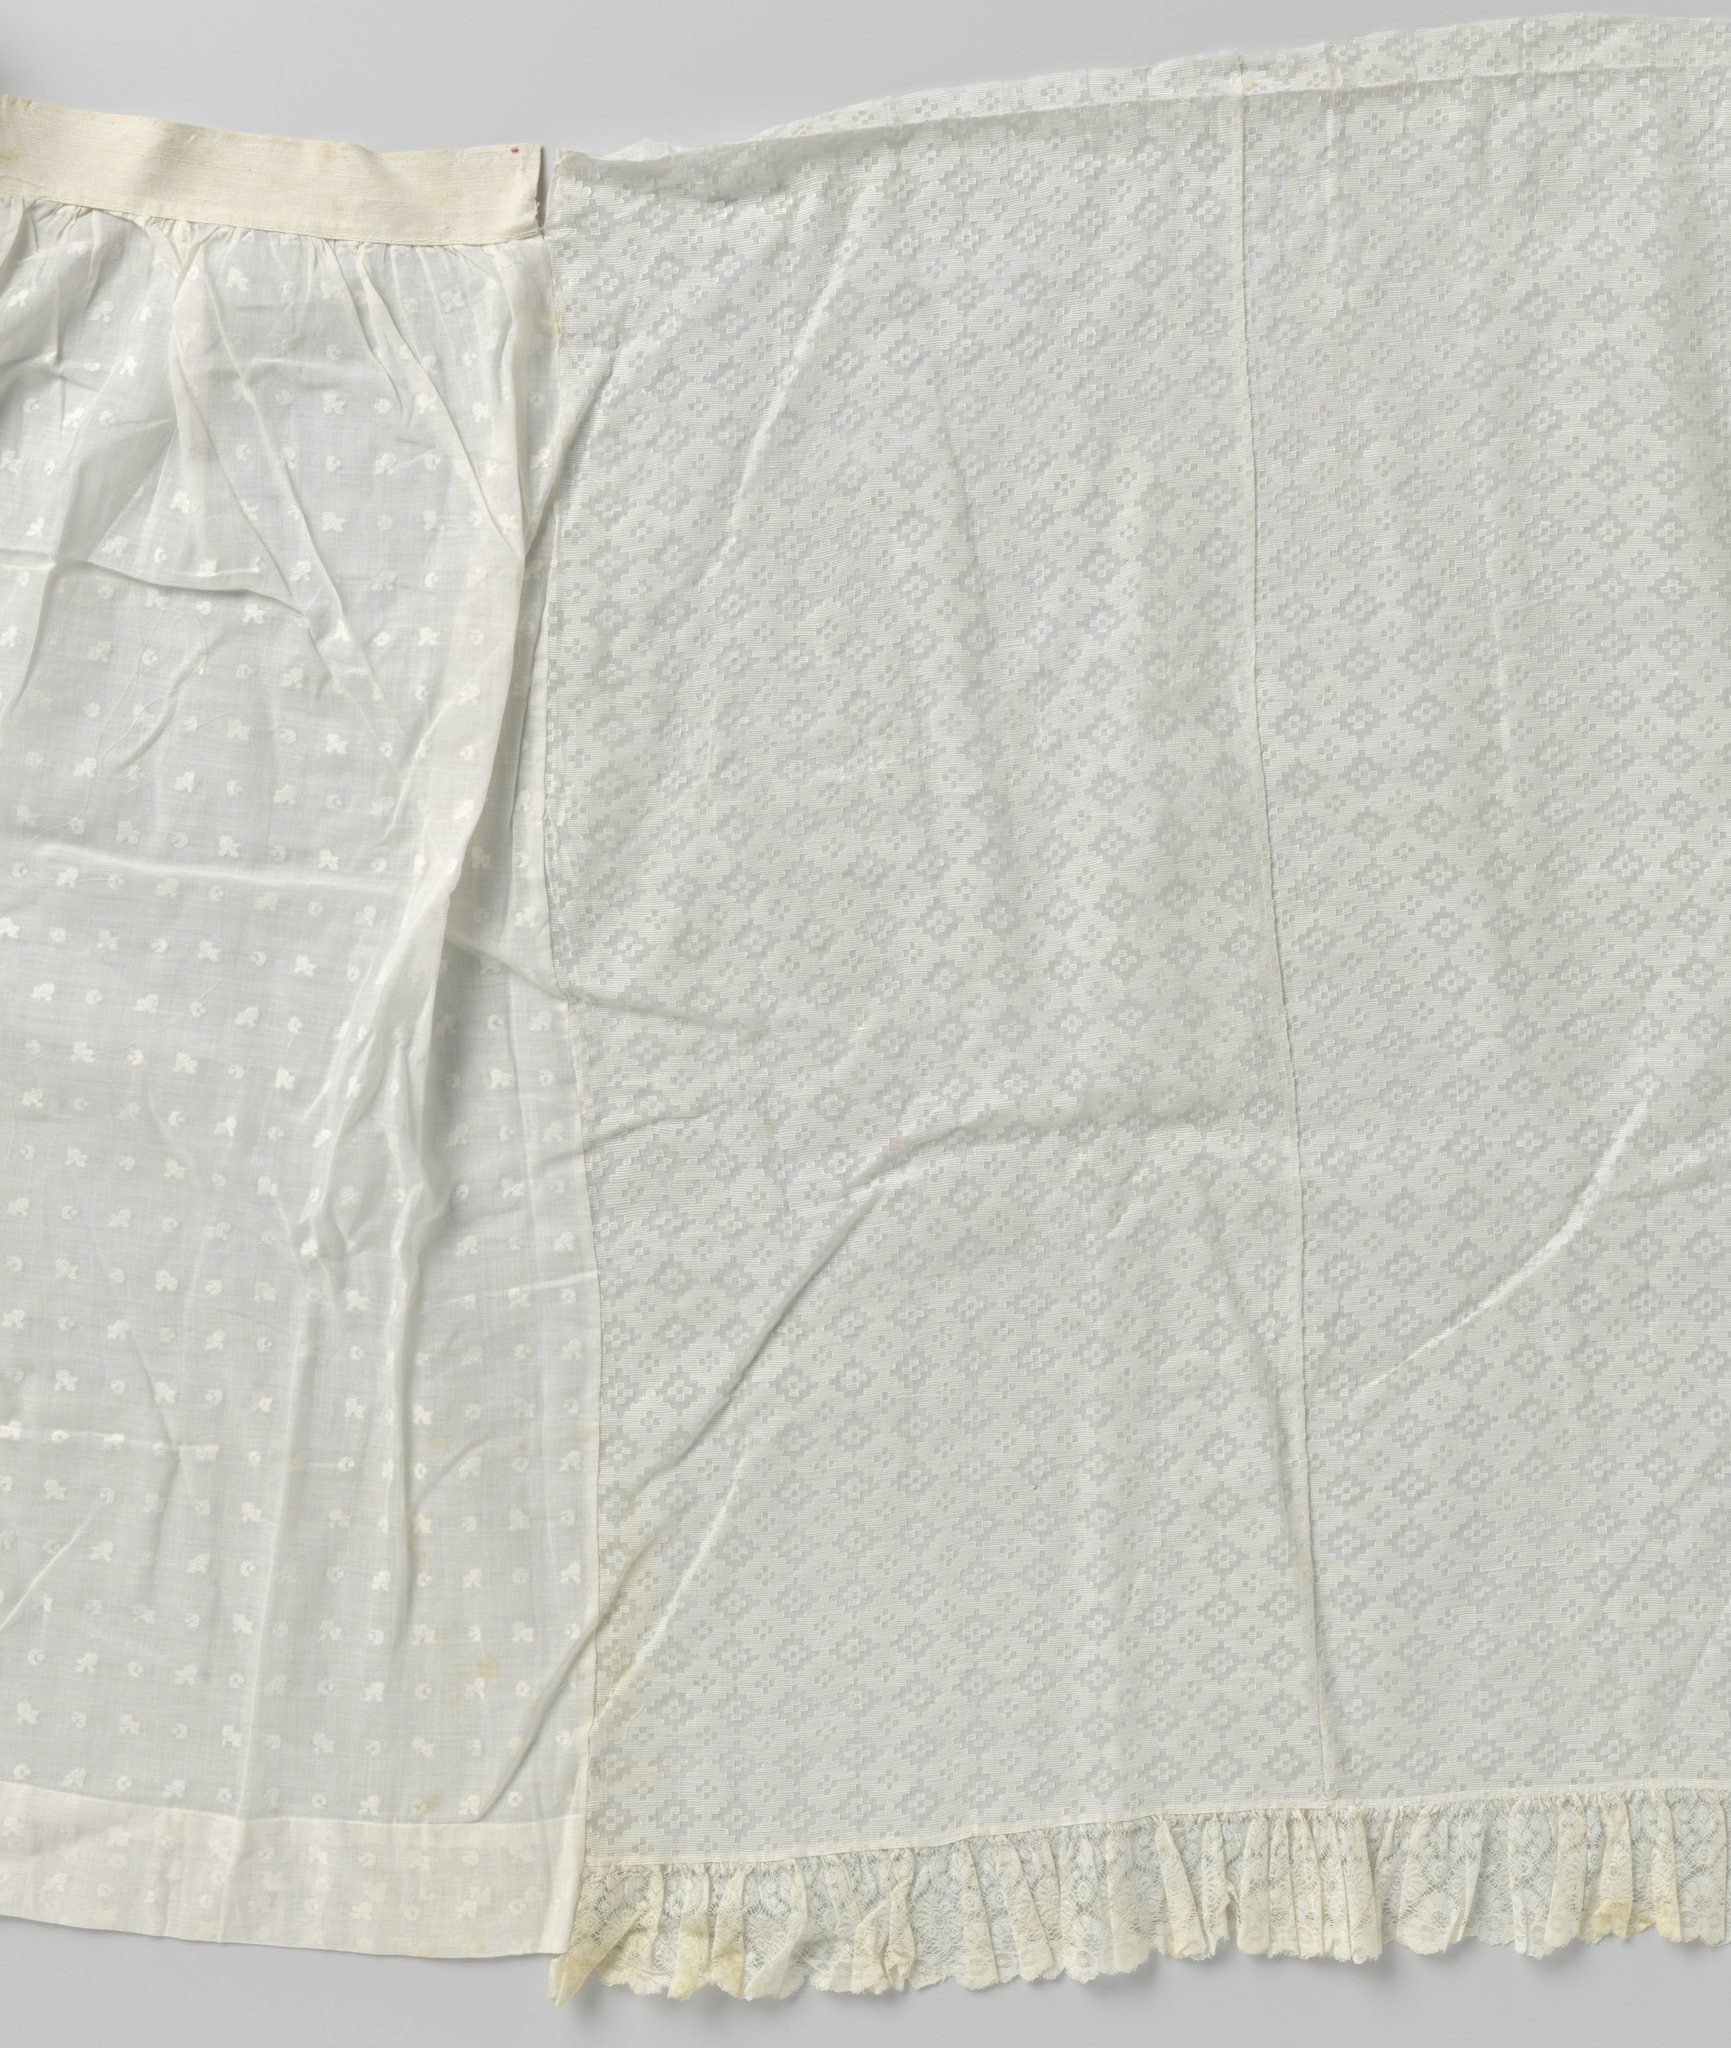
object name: val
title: Val van batist, voor een toilettafel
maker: Anonymous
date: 1800-1920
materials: textile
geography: netherlands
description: Batisten val voor een toilettafel in een boudoir.